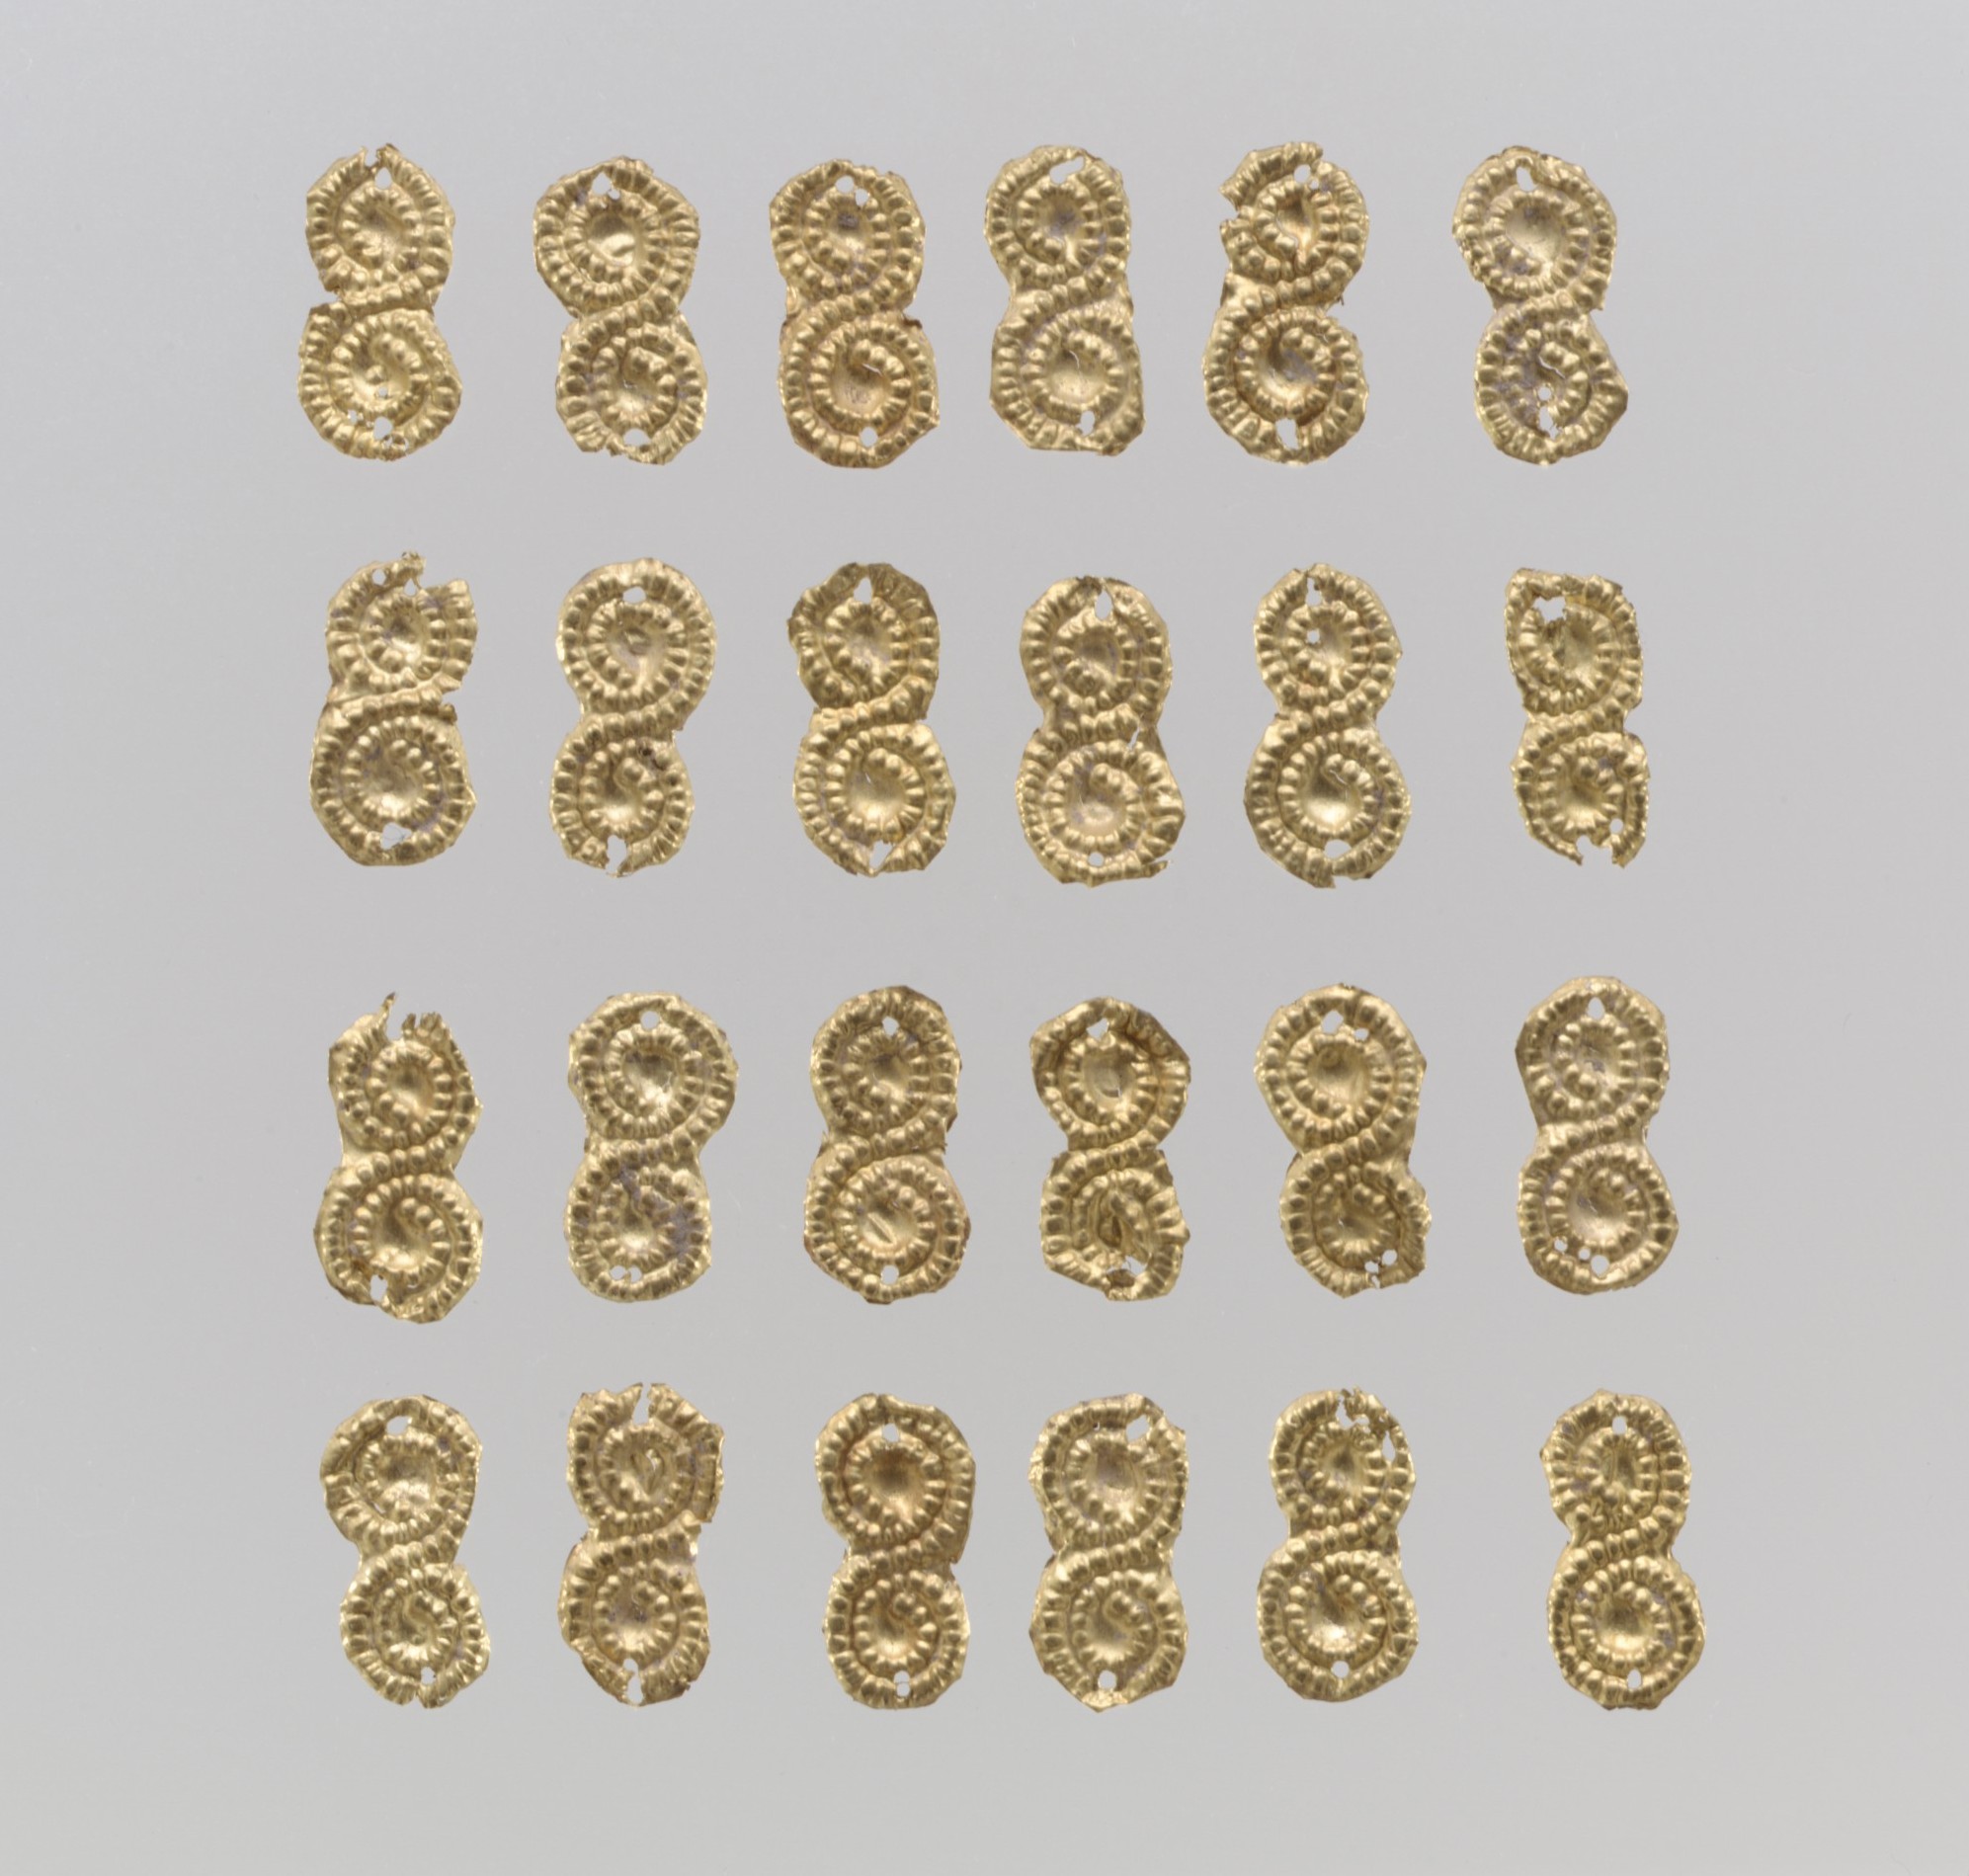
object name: sheet applique, 37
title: Gold sheet appliques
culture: east germanic or nomadic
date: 401-450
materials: gold